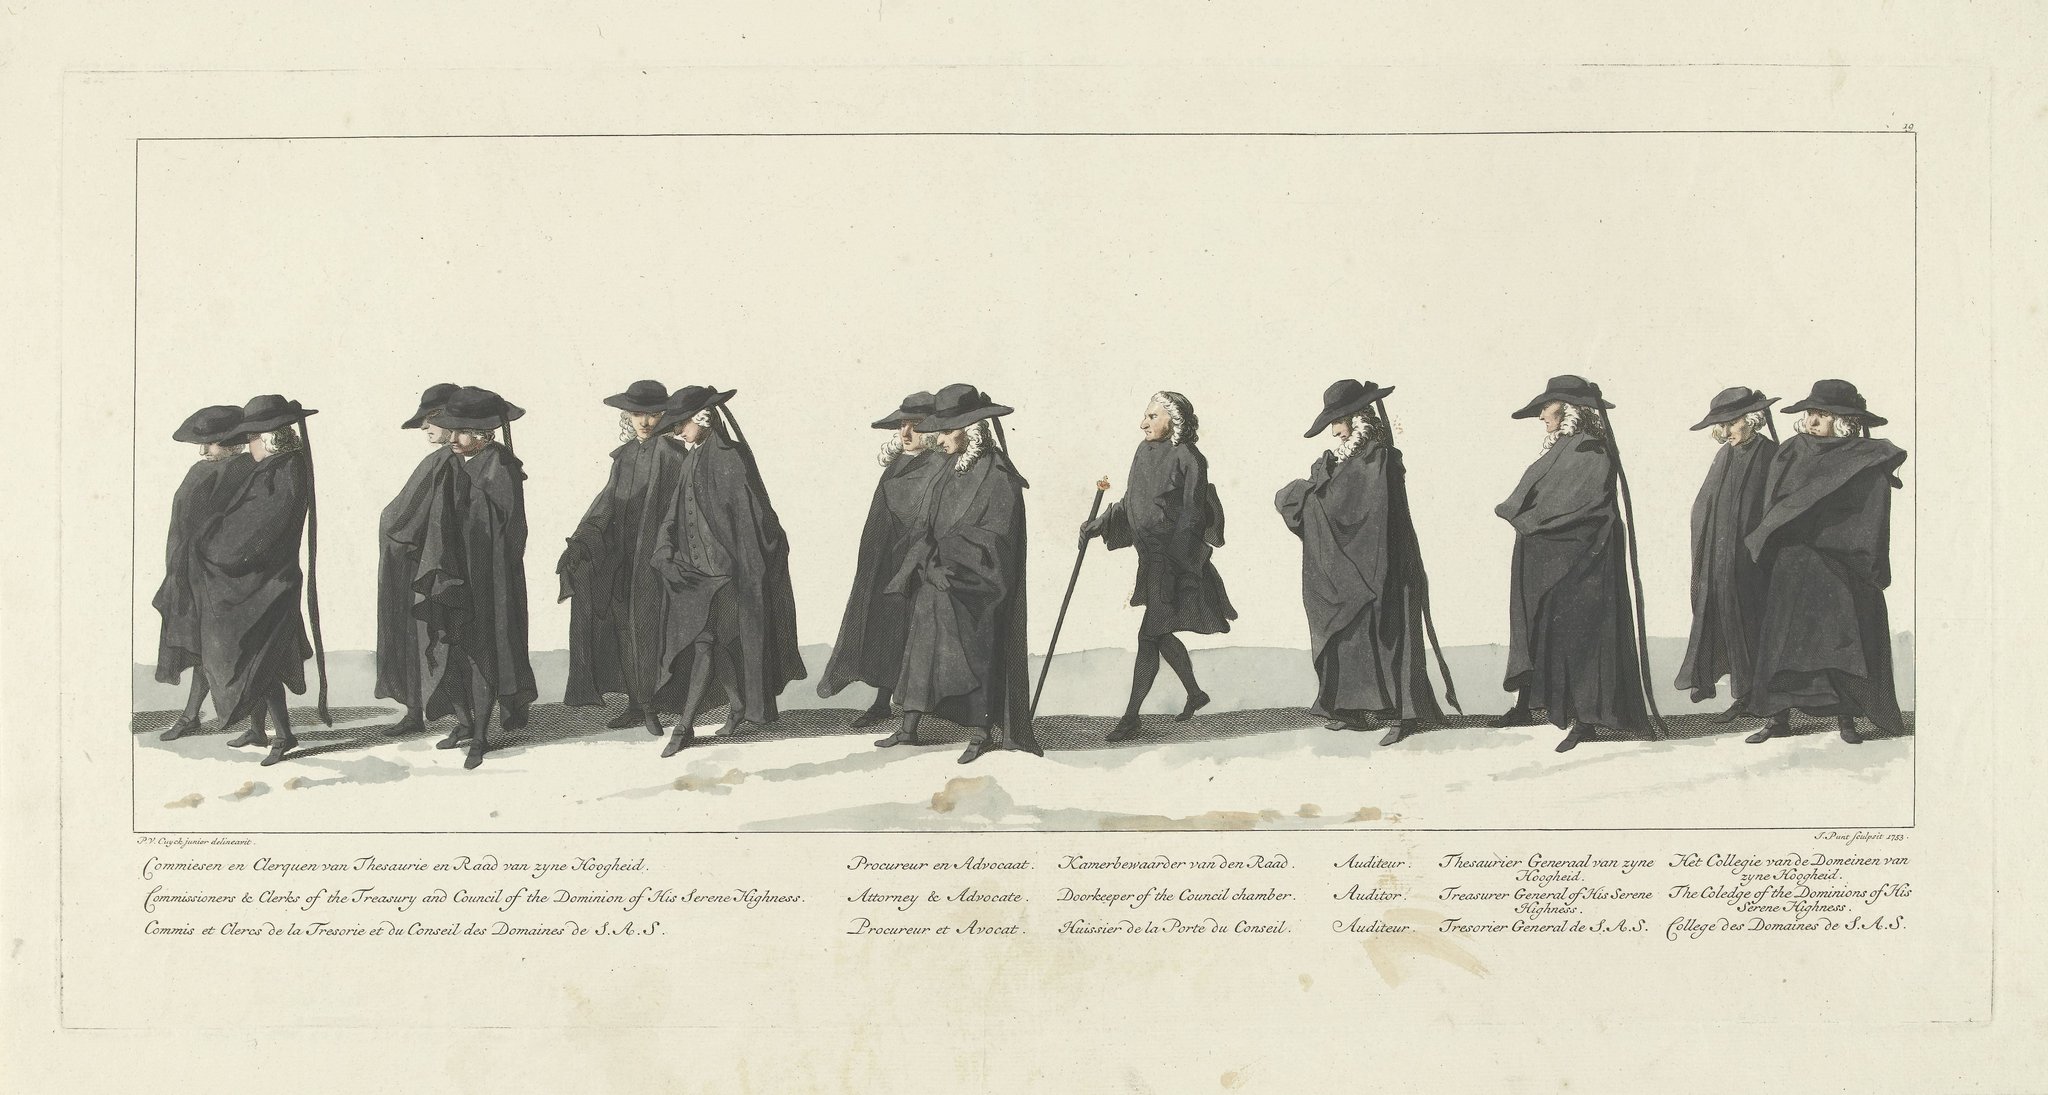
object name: print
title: Commiesen en Clerquen van Thesaurie en Raad van zyne Hoogheid (...)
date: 1753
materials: paper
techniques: engraving, etching, hand coloring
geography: northern netherlands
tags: the hague, willem iv (prins van oranje-nassau), cortege, funeral procession, royal household; courtiers, retinue, train, delft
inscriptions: collector's mark: Lugt 2228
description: Leden van het stadhouderlijk bestuurlijk apparaat. In de marge het onderschrift in Nederlands, Frans en Engels. Onderdeel van een serie van 41 platen van de begrafenisstoet van stadhouder Willem IV te Delft op 4 februari 1752. Genummerd rechtsboven: 19.